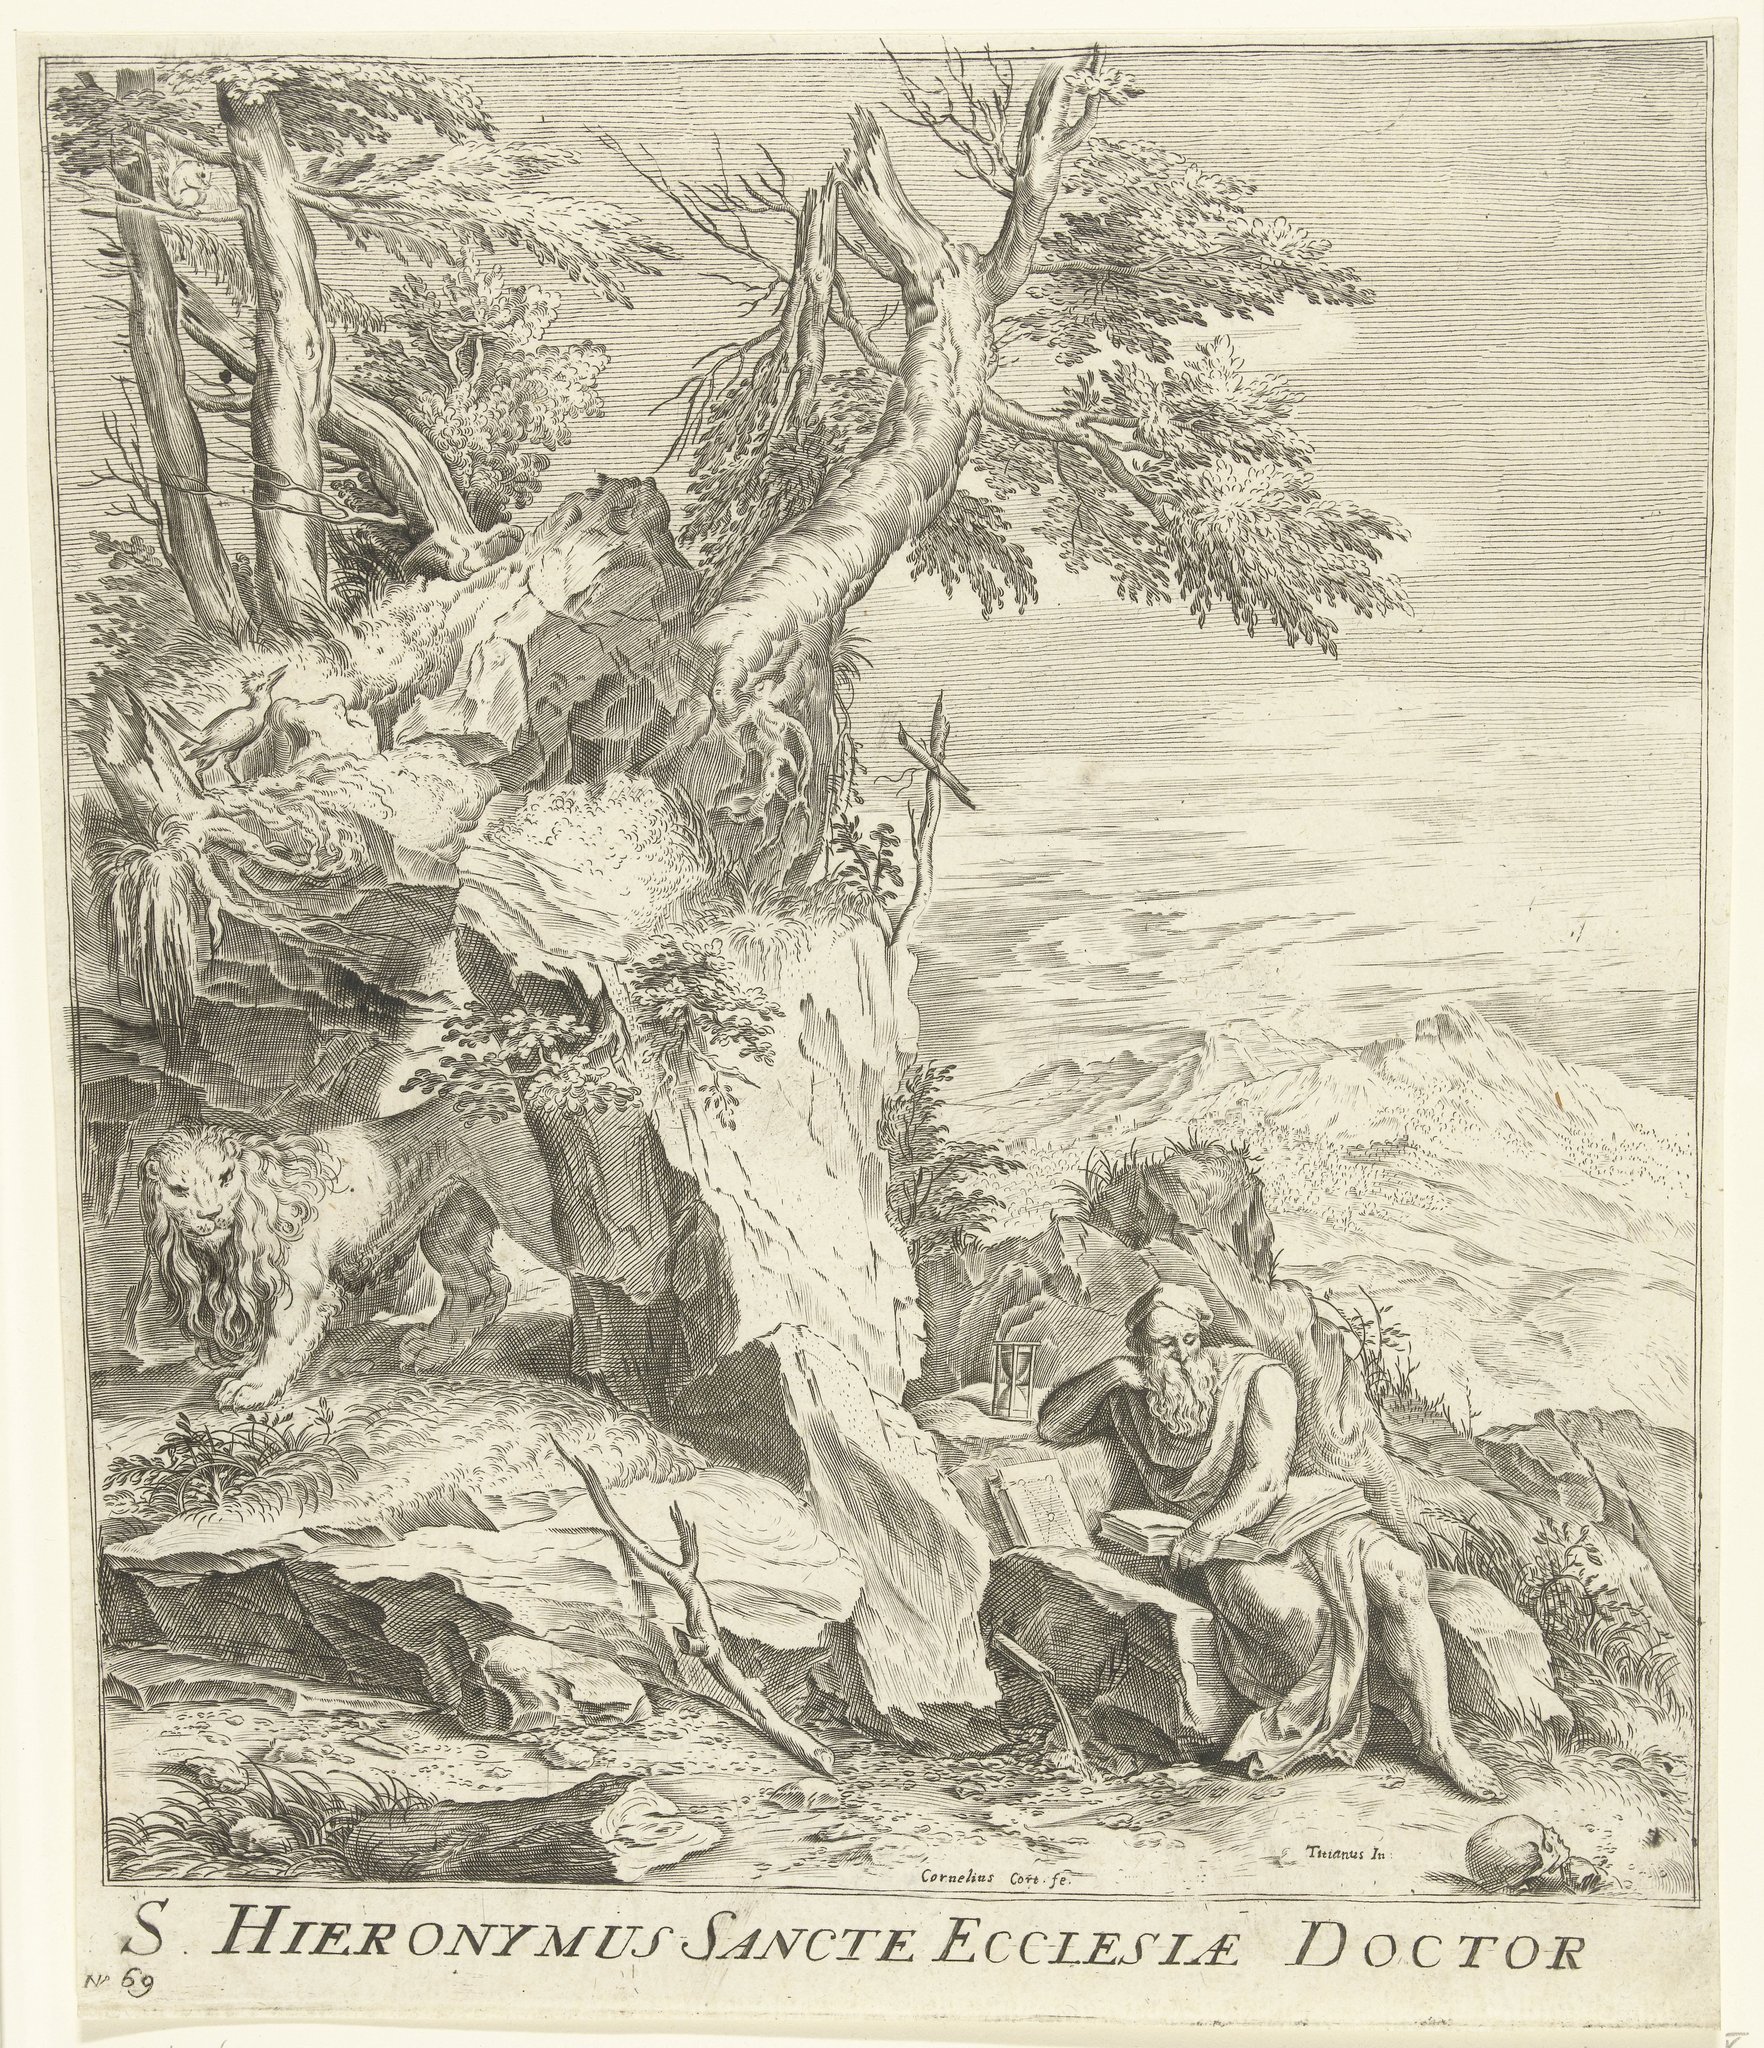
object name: print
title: Landschap met lezende Hieronymus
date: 1565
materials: paper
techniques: engraving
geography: rome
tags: the monk and hermit jerome (hieronymus); possible attributes: book, cardinal's hat, crucifix, hour-glass, lion, skull, stone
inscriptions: collector's mark: Lugt 2228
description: De heilige Hieronymus zit in een bergachtig landschap op een rots te lezen. Naast hem een boek en een zandloper. De leeuw, zijn attribuut, struint tussen de rotsen.